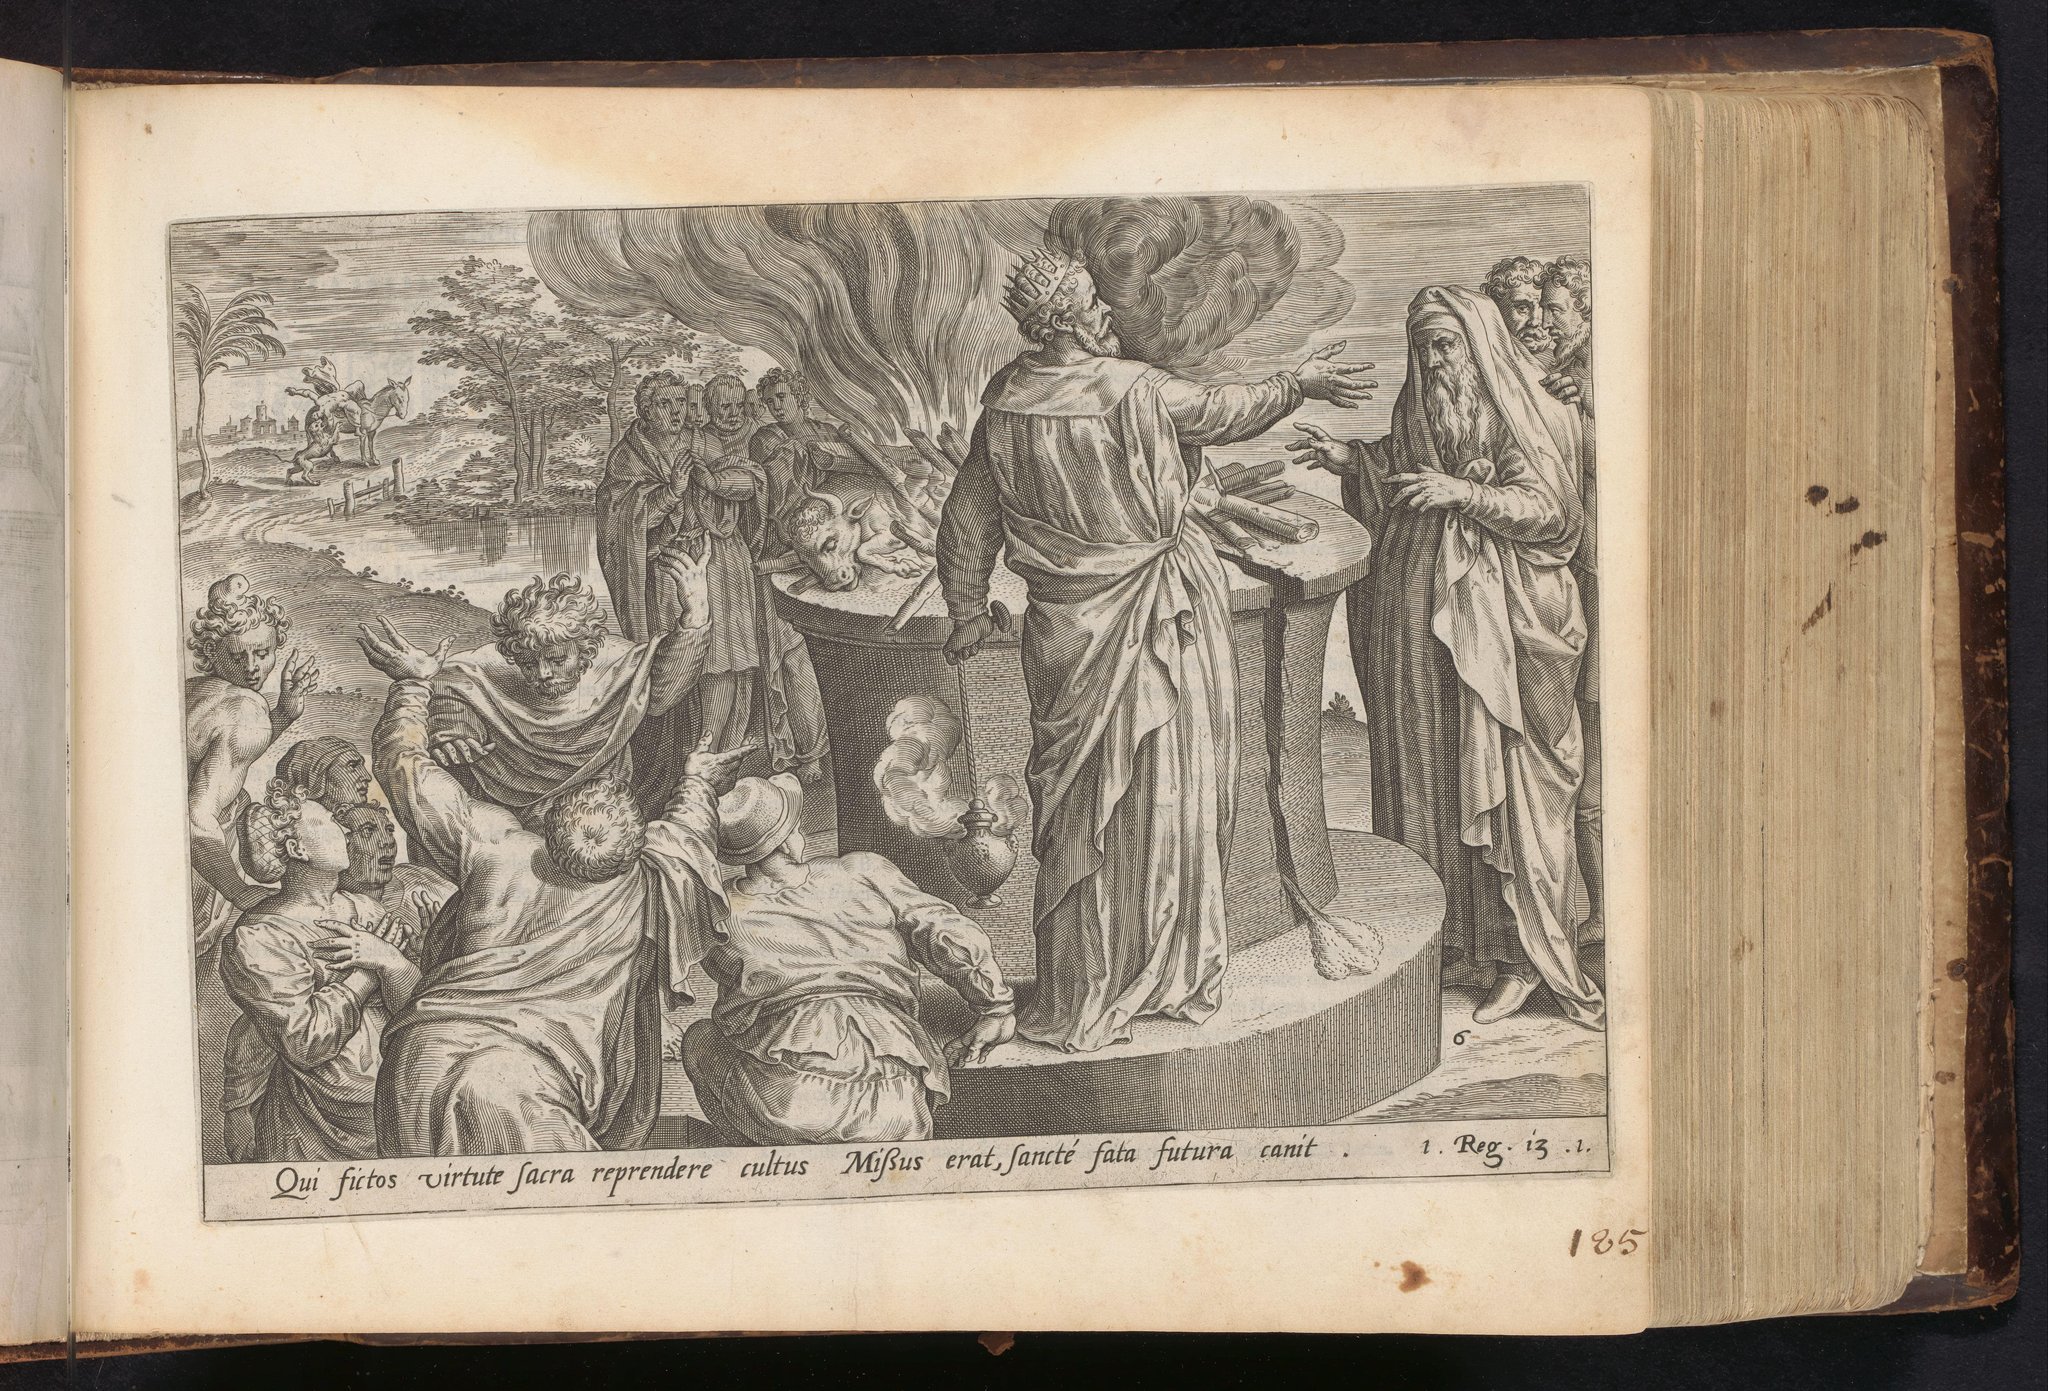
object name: album leaf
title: Koning Jerobeam en de godsman voor het altaar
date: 1579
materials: paper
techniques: engraving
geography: alkmaar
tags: 'a man of god' from judah comes to bethel and prophesies to jeroboam the destruction of the altar, as king jeroboam points to the prophet and orders his seizure, his hand withers and the altar falls apart, the prophet of judah rides off with his donkey and on his way is killed by a lion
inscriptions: number: ‘185’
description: Koning Jerobeam brengt een offer aan een afgod als een godsman uit Juda verschijnt. De godsman profeteert en kondigt het wonder aan dat het altaar zal splijten en de as op de grond zal vallen. De uitgestrekte arm van Jerobeam verstijft als hij de opdracht geeft de godsman gevangen te nemen. Links op de achtergrond is het einde van de godsman verbeeld. De godsman wordt gedood door een leeuw en van zijn ezel getrokken. Onder de voorstelling een verwijzing in het Latijn naar de Bijbeltekst in 1 Kon. 13:1. Deze prent maakt deel uit van een album.